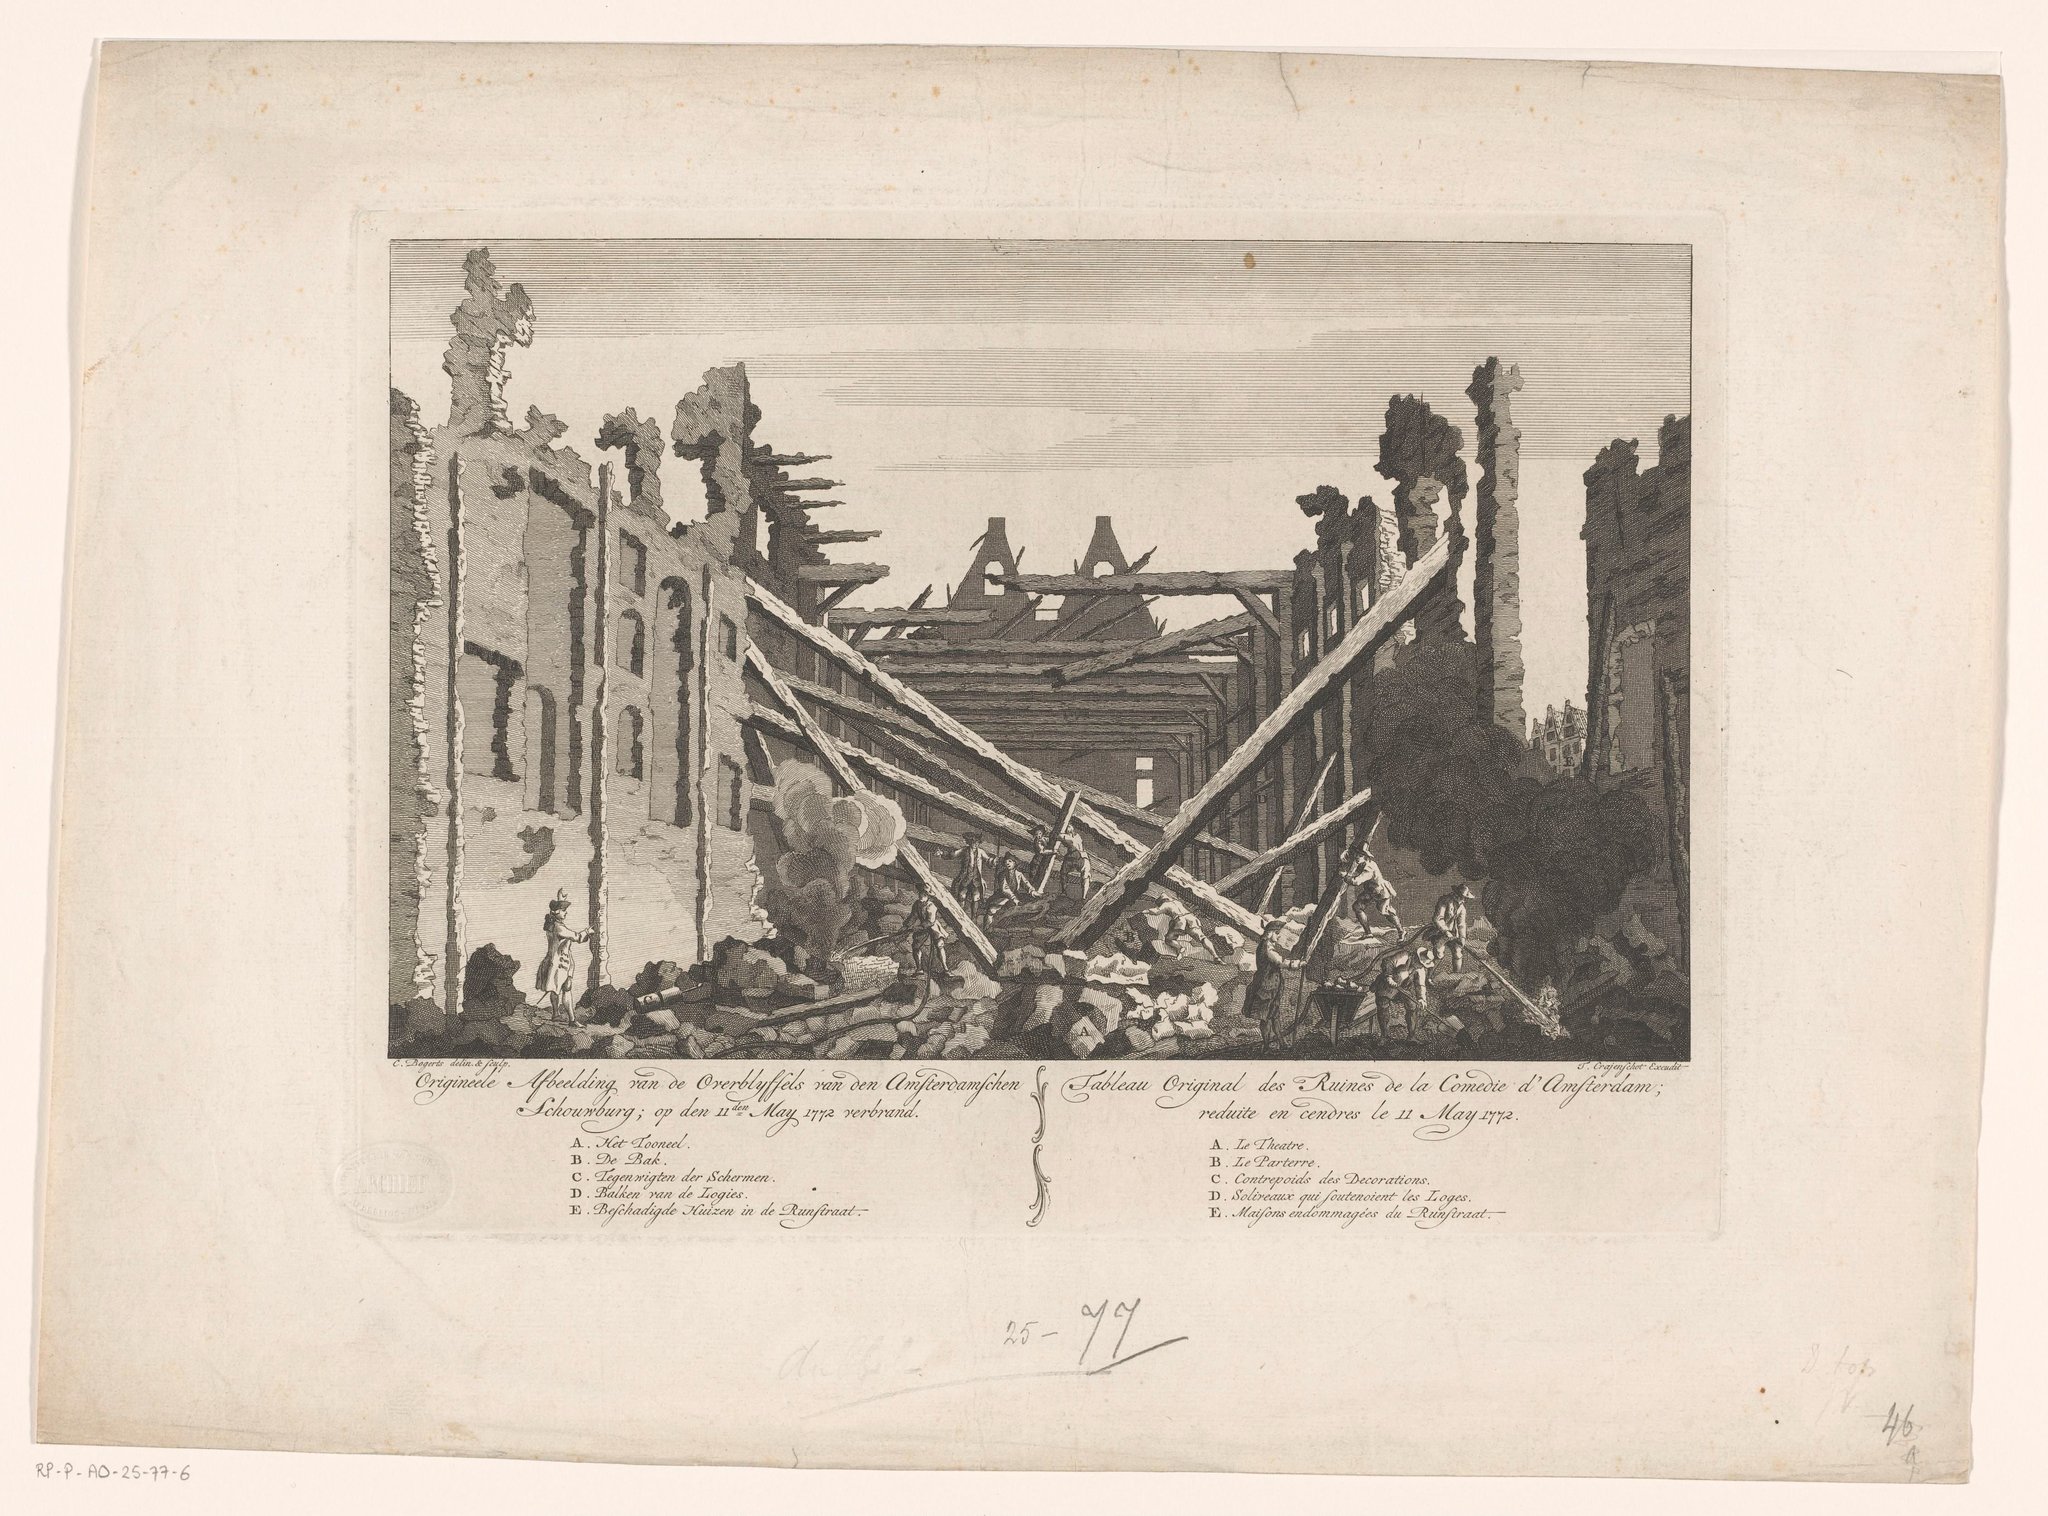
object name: print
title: Ruïne van de afgebrande schouwburg aan de Keizersgracht te Amsterdam, 1772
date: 1772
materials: paper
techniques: engraving, etching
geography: amsterdam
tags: on fire, ablaze, theatre, theatrical performance, ruin of a building ~ architecture, theatre (building), fire-fighting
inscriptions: check stamp: ‘Archief Ministerie van Oorlog Afdeeling Genie’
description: Gezicht op de ruïne van de Amsterdamse Schouwburg aan de Keizersgracht na de brand van 11 mei 1772. Brandweerlieden blussen met waterspuiten de laatste vuurhaarden, anderen ruimen puin. Onder de voorstelling de titel en legenda A-E in het Nederlands (links) en Frans (rechts). Onderdeel van een serie van vier prenten met titelprent over de brand in de Amsterdamse Schouwburg.